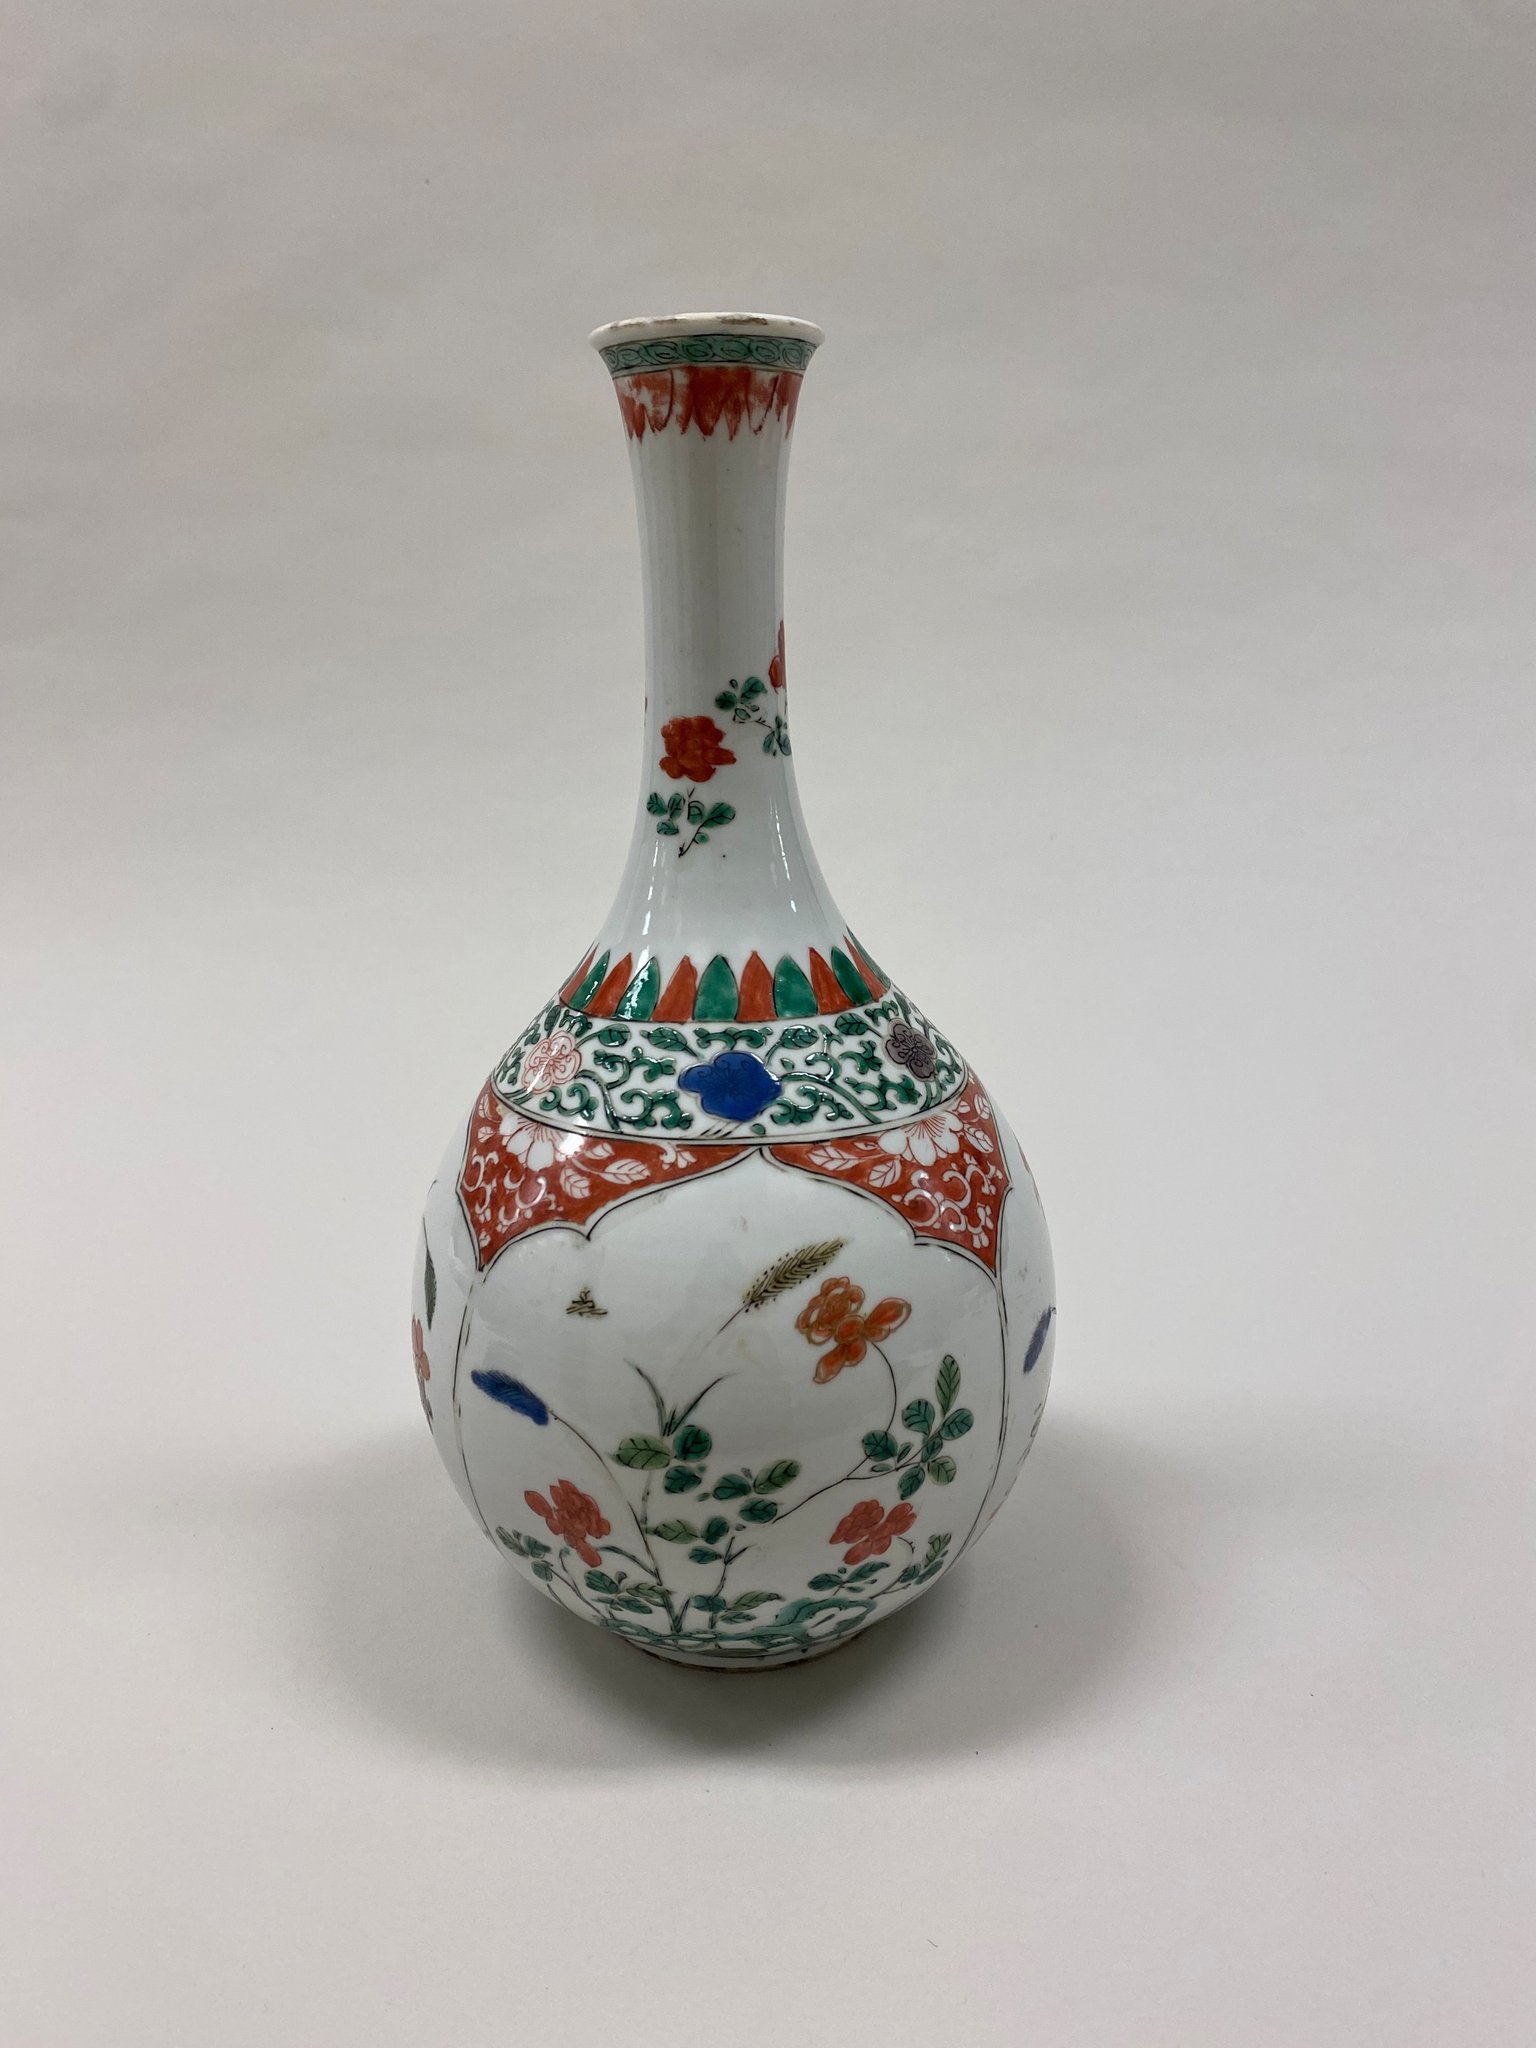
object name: vase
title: Vase with flowers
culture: chinese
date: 1667-1733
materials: enamel, porcelain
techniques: overglaze, painting, polychrome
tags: flowers